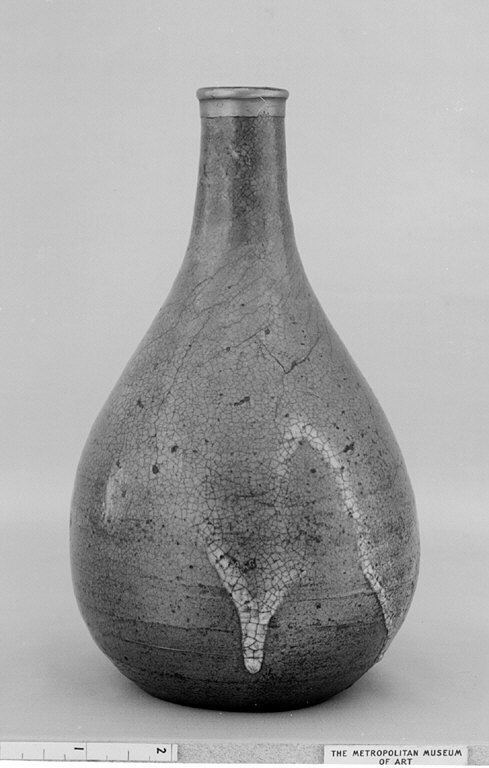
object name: bottle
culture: japanese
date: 1701-1800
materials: clay, glaze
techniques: overglaze